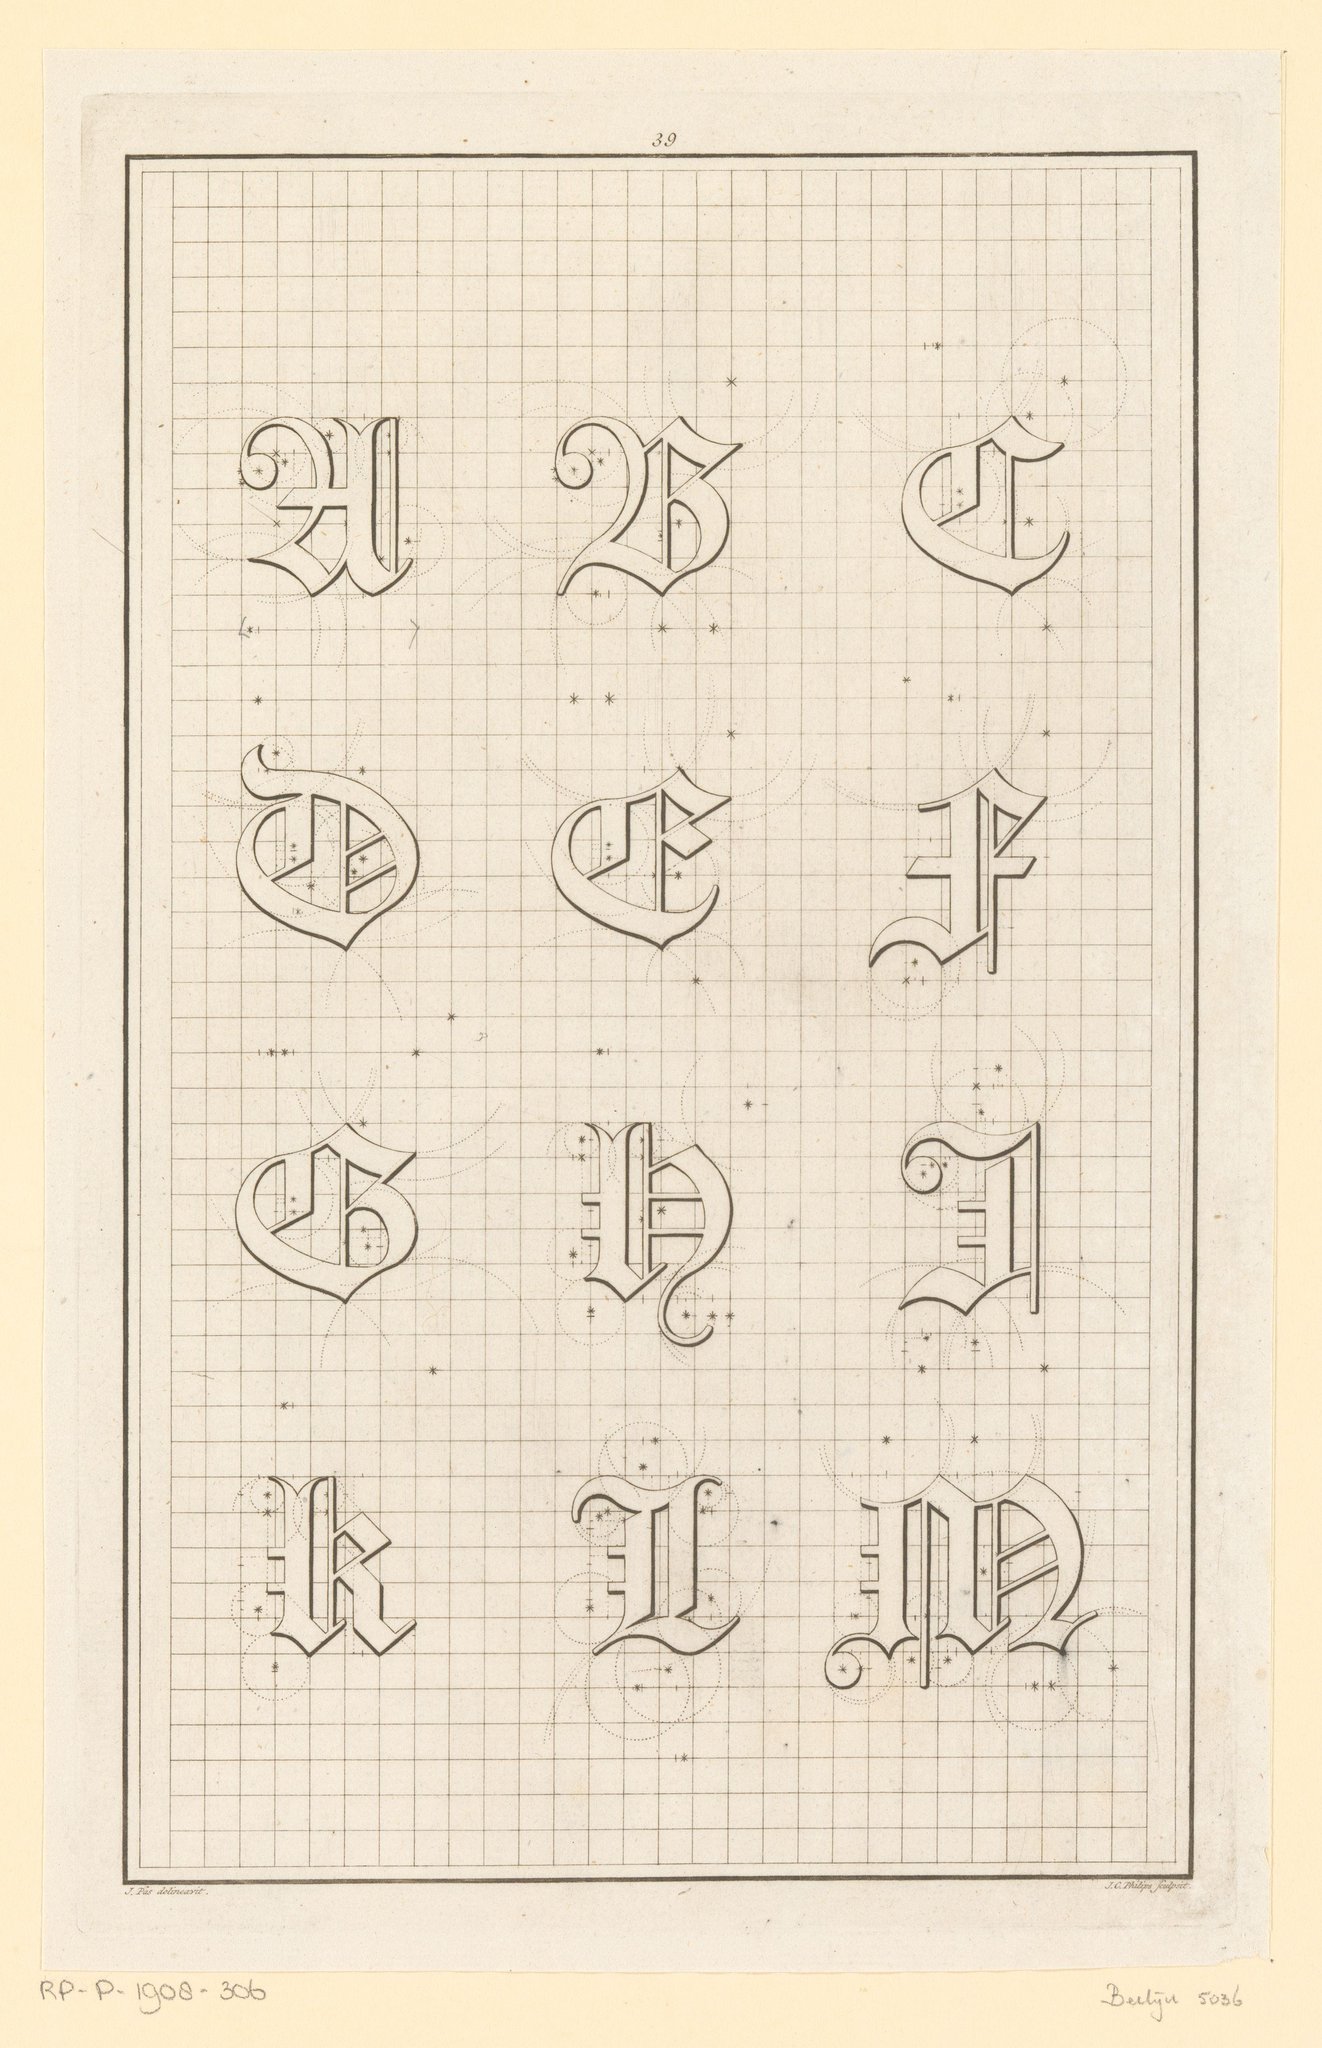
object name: ornament print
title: Mathematische Of Wiskundige Behandeling Der Schriftkonst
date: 1737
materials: paper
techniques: engraving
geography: amsterdam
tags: calligraphy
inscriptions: collector's mark: Lugt 2228